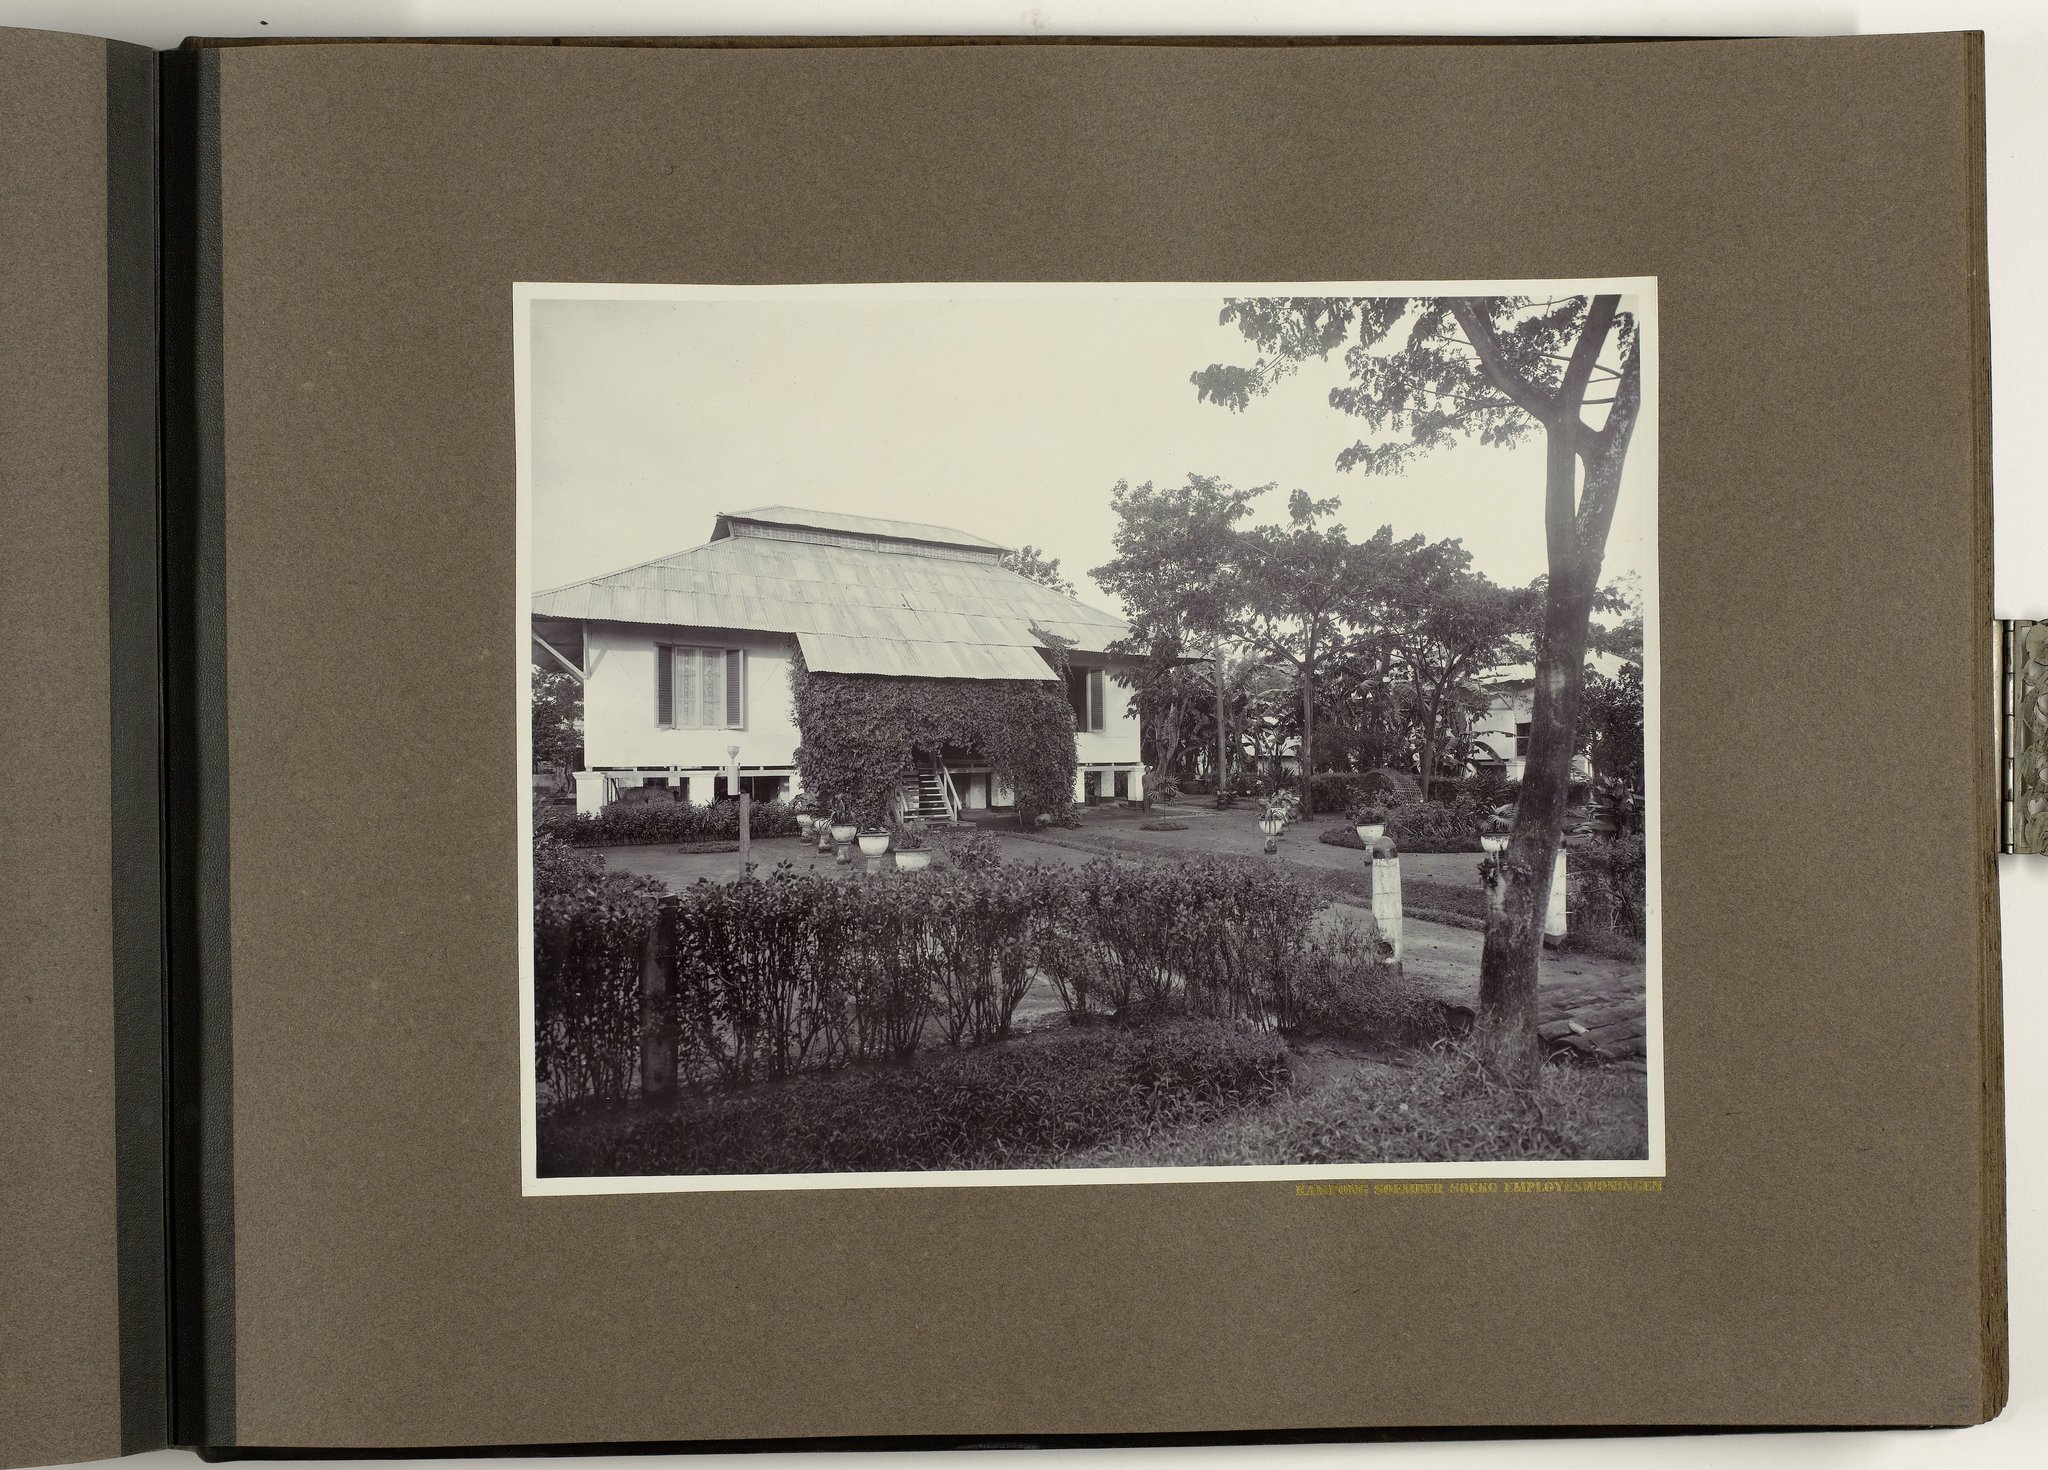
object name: photograph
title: Kampong Soember Soeko employéswoningen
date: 1917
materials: photographic support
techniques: gelatin silver print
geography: jatiroto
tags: colonial system, (non-fruit) products of plants or trees: sugarcane, rural housing, e.g. country-house, villa, cottage, public road in village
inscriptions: inscription: ‘KAMPONG SOEMBER SOEKO EMPLOYÉSWONINGEN’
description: Werknemerswoningen in het dorp Soember Soeko. Witte huizen op palen, met gazons, bomen en planten in tuinvazen. Onderdeel van het fotoalbum aangeboden aan F.J. Wirix door het personeel van de Suikeronderneming Djatiroto in 1917.